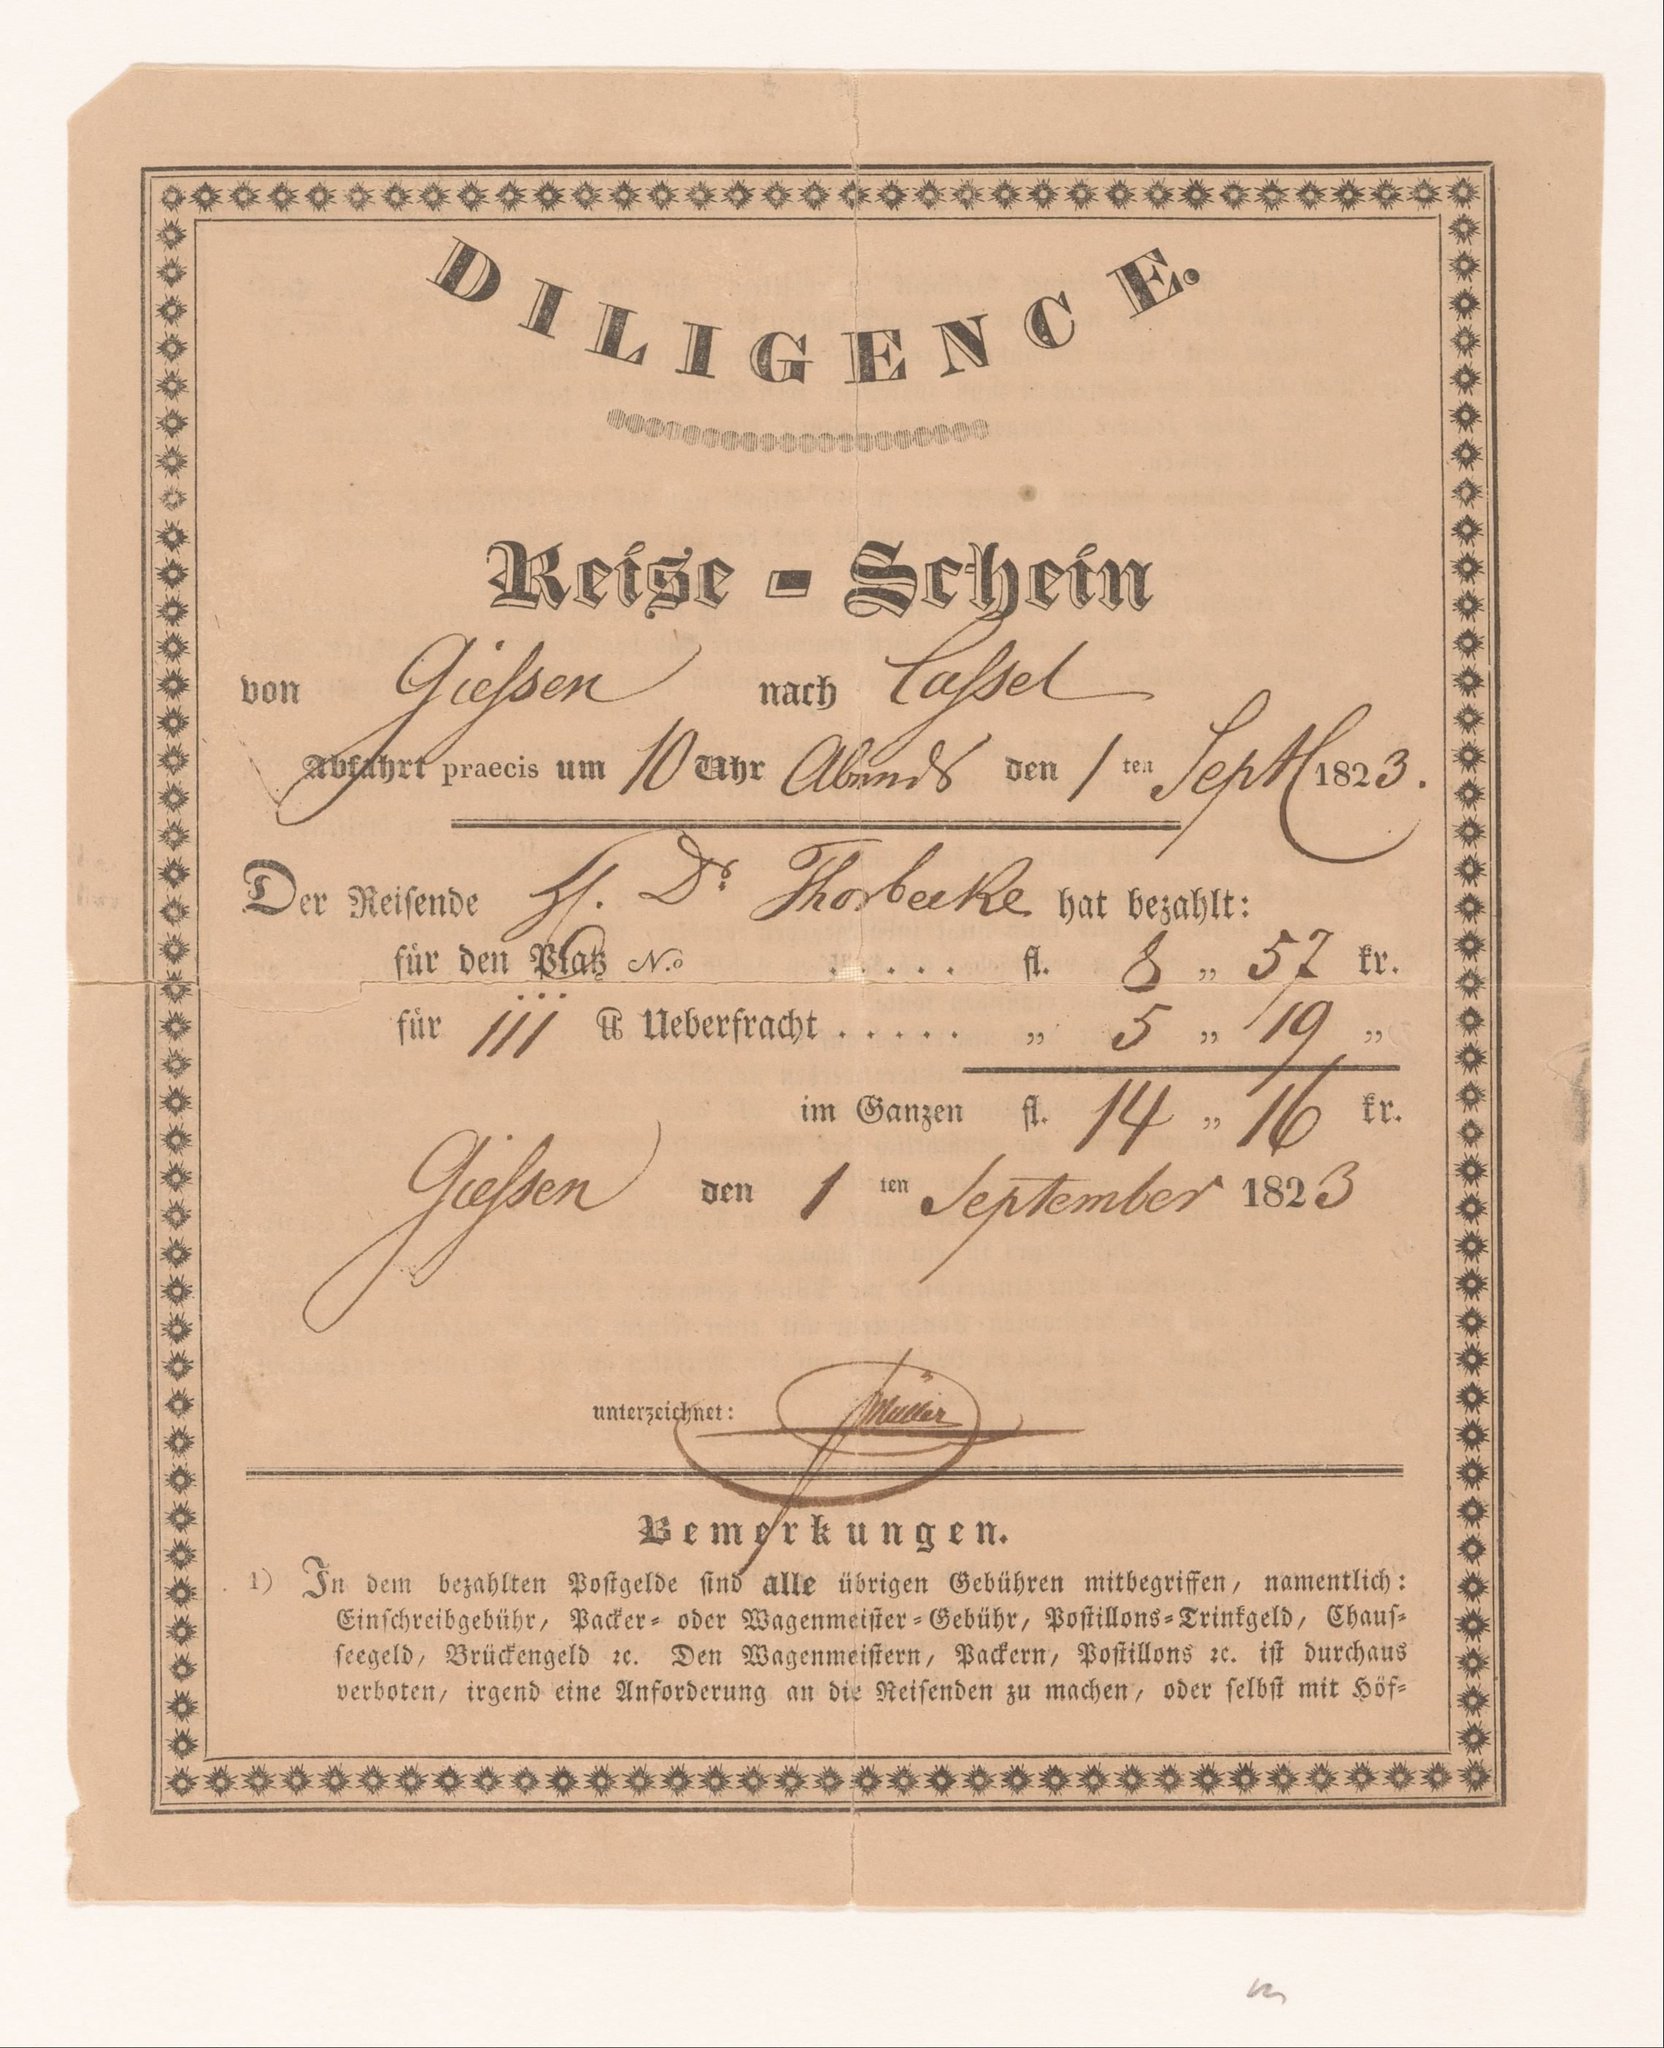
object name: document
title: Diligence Reise-Schein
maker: Anonymous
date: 1823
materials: ink, paper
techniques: printing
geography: germany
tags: the hague, johan rudolf thorbecke, germany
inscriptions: date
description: Thorbeckes diligence reisbiljet Giessen Kassel van 1 september 1823.